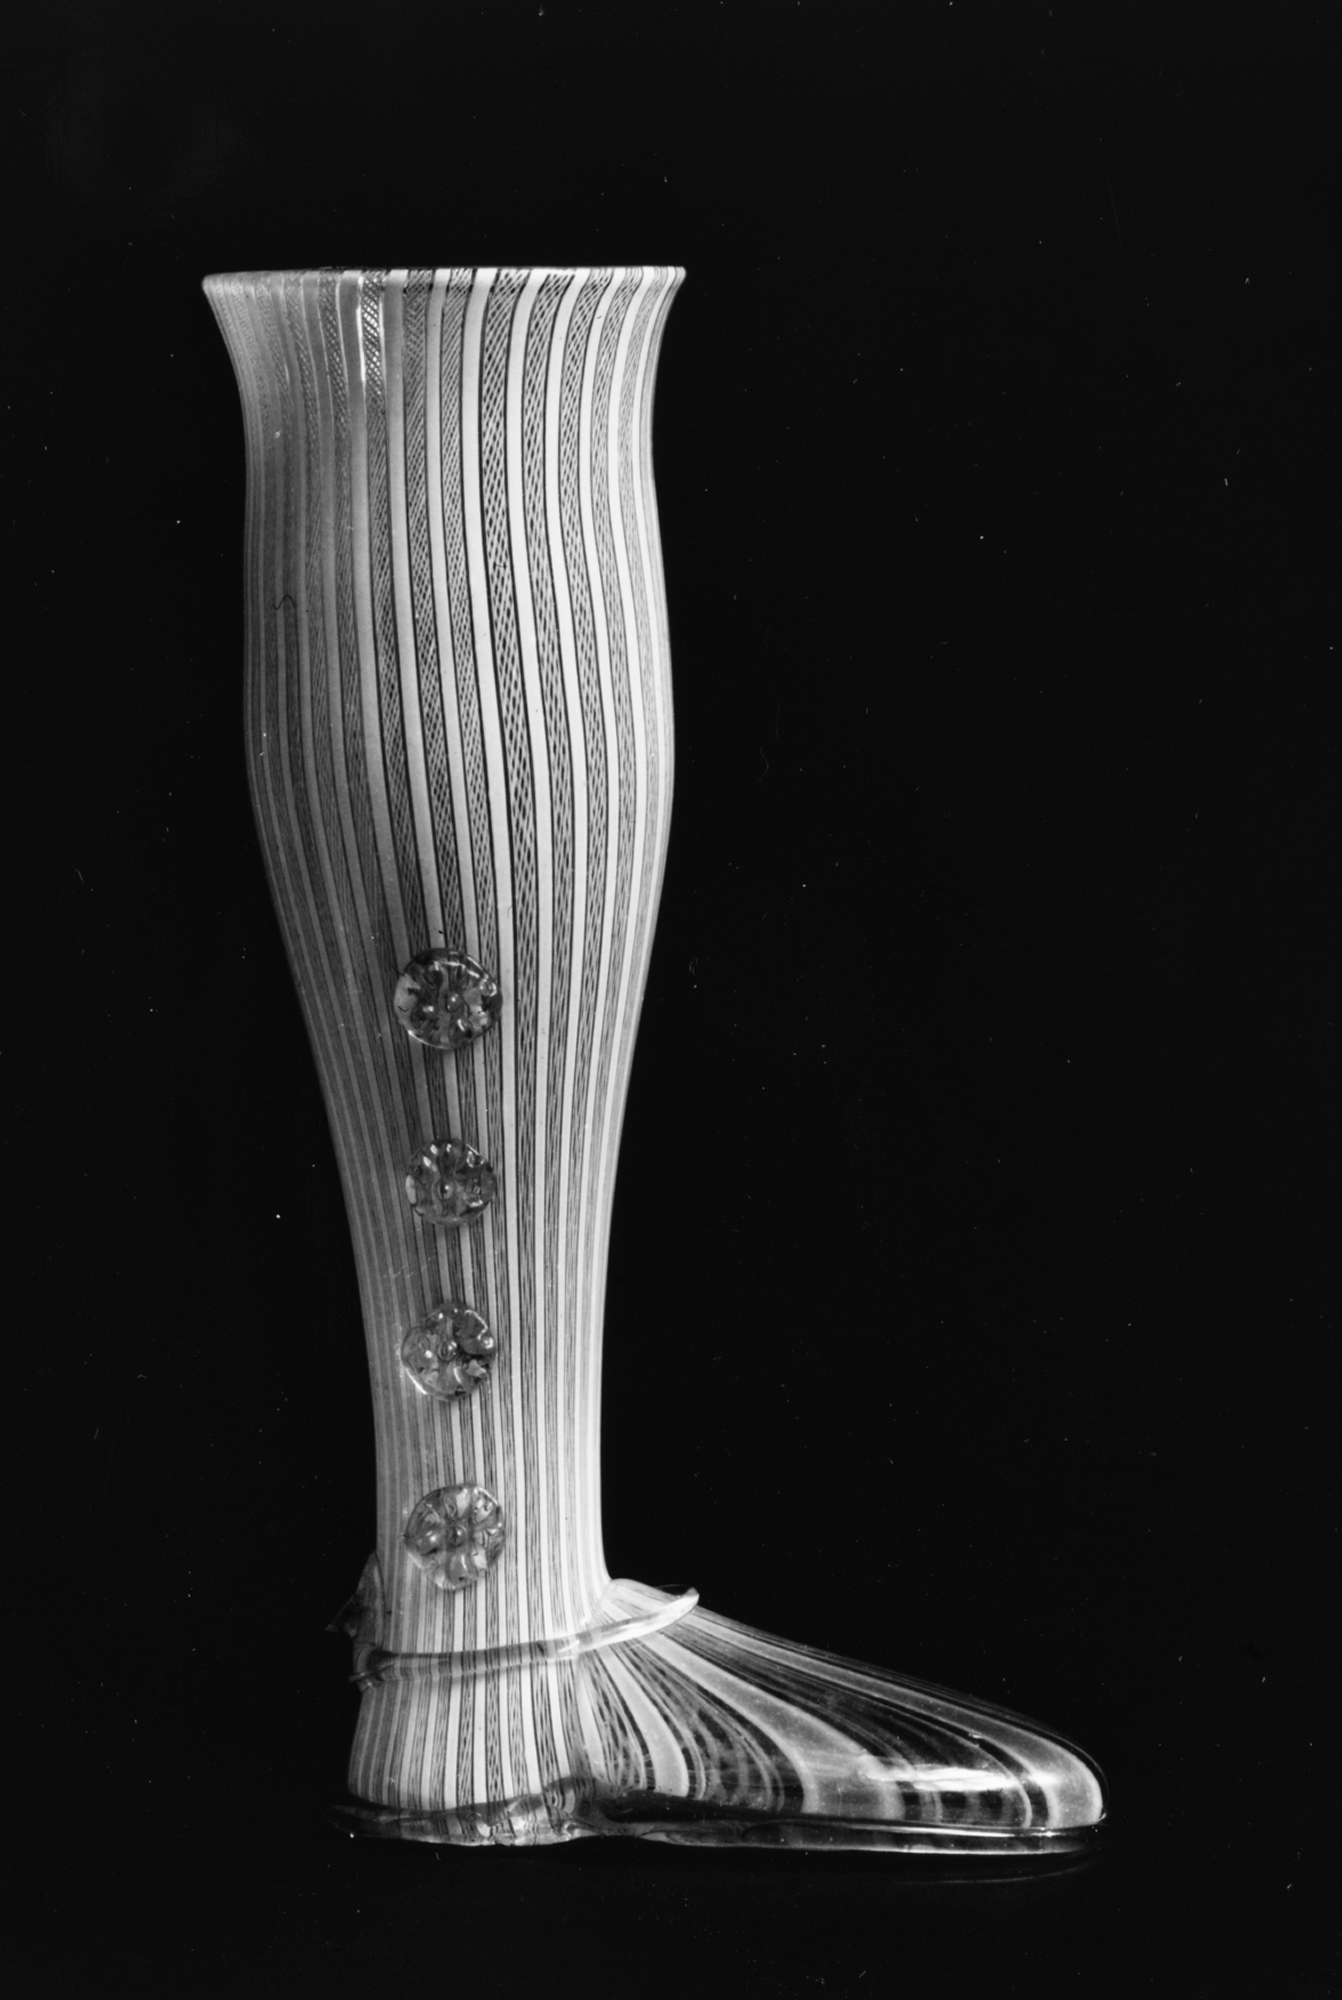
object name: glass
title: Boot glass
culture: venetian or façon de venise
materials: gilt, glass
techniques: glassblowing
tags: boots